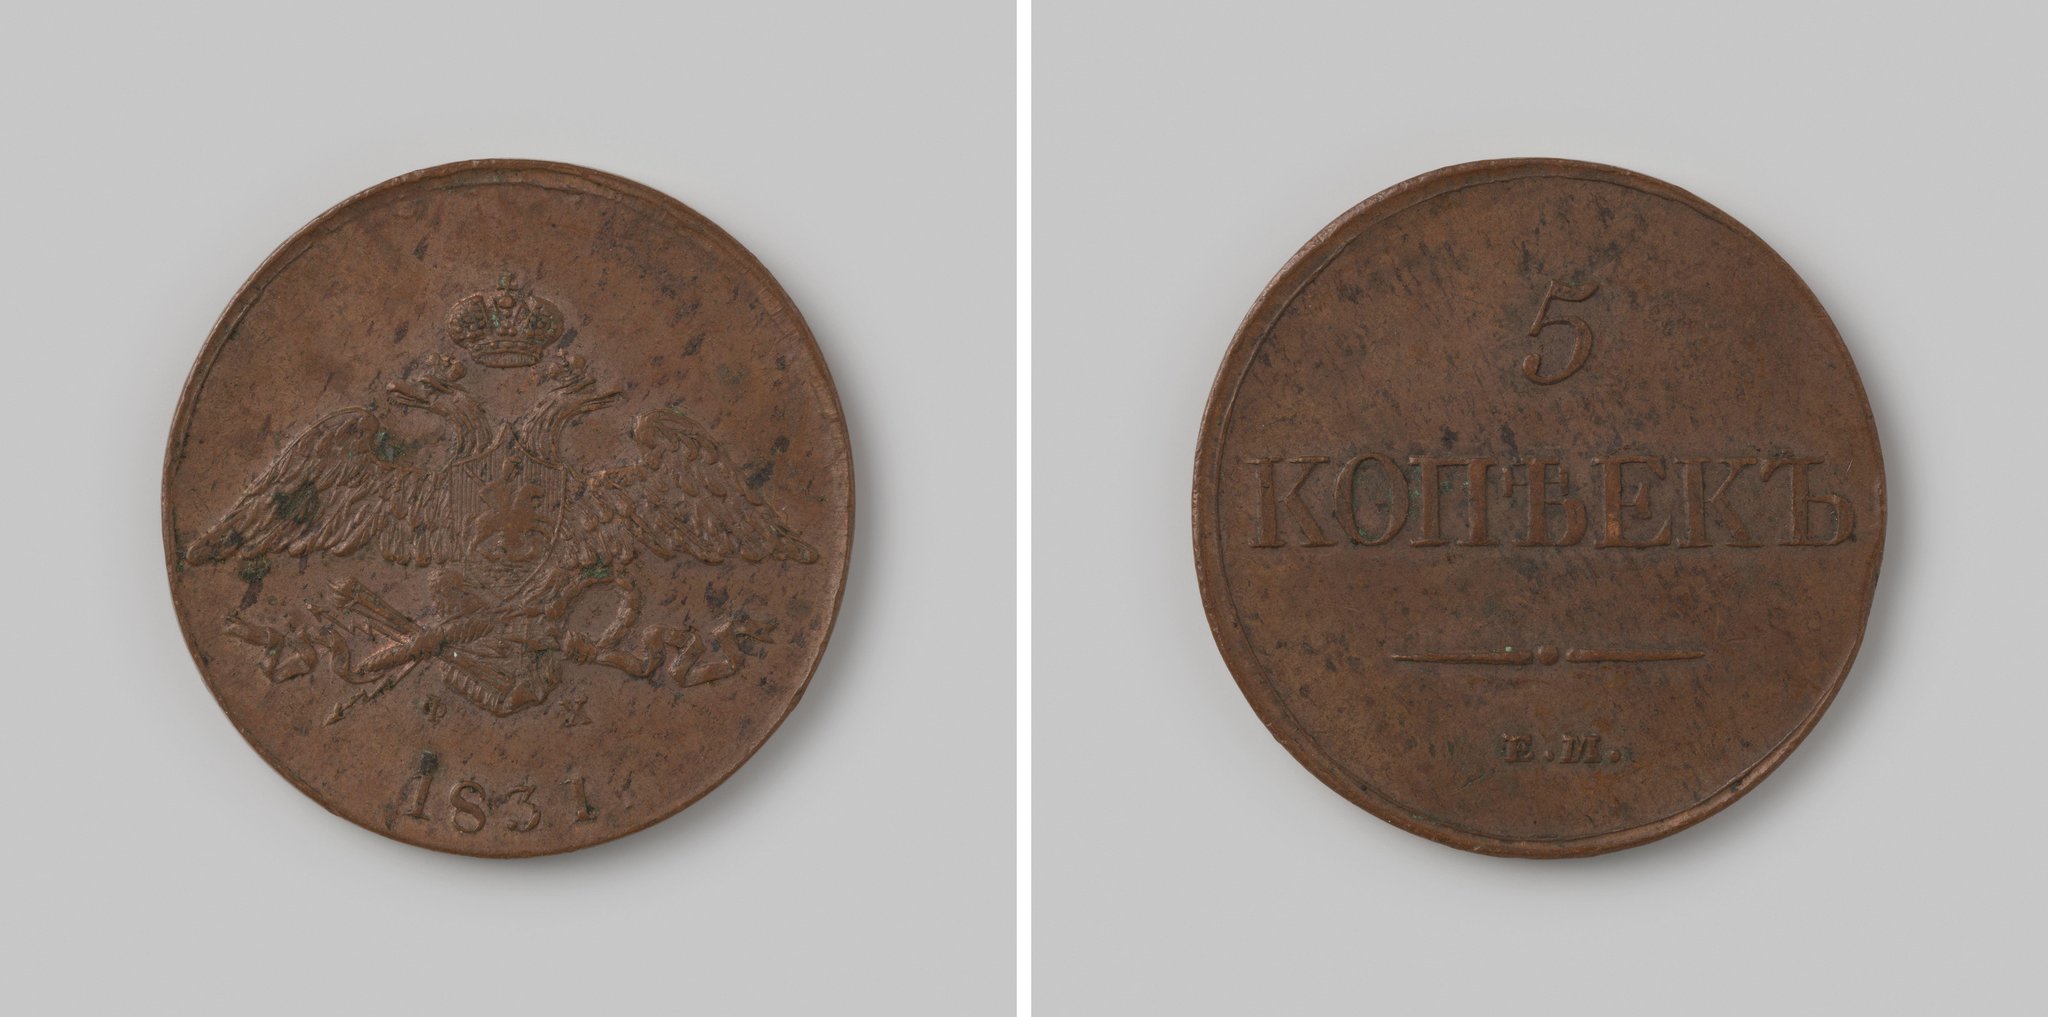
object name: coin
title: Rusland, tsaar Nikolai I, 5 kopeken, 1831 EM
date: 1831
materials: copper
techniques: striking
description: Koperen munt. Voorzijde: dubbelkoppige gekroonde adelaar met gespreide vleugels en met op zijn bosrt een wapenschild en onder op zijn staart verschillende attributen. Daaronder jaartal. Boven de adelaar een kroon. Keerzijde: in twee regels waarde-aanduiding, waaronder in het Cyrillisch de letters E en M [=Ekaterinenburg]. Gladde rand.